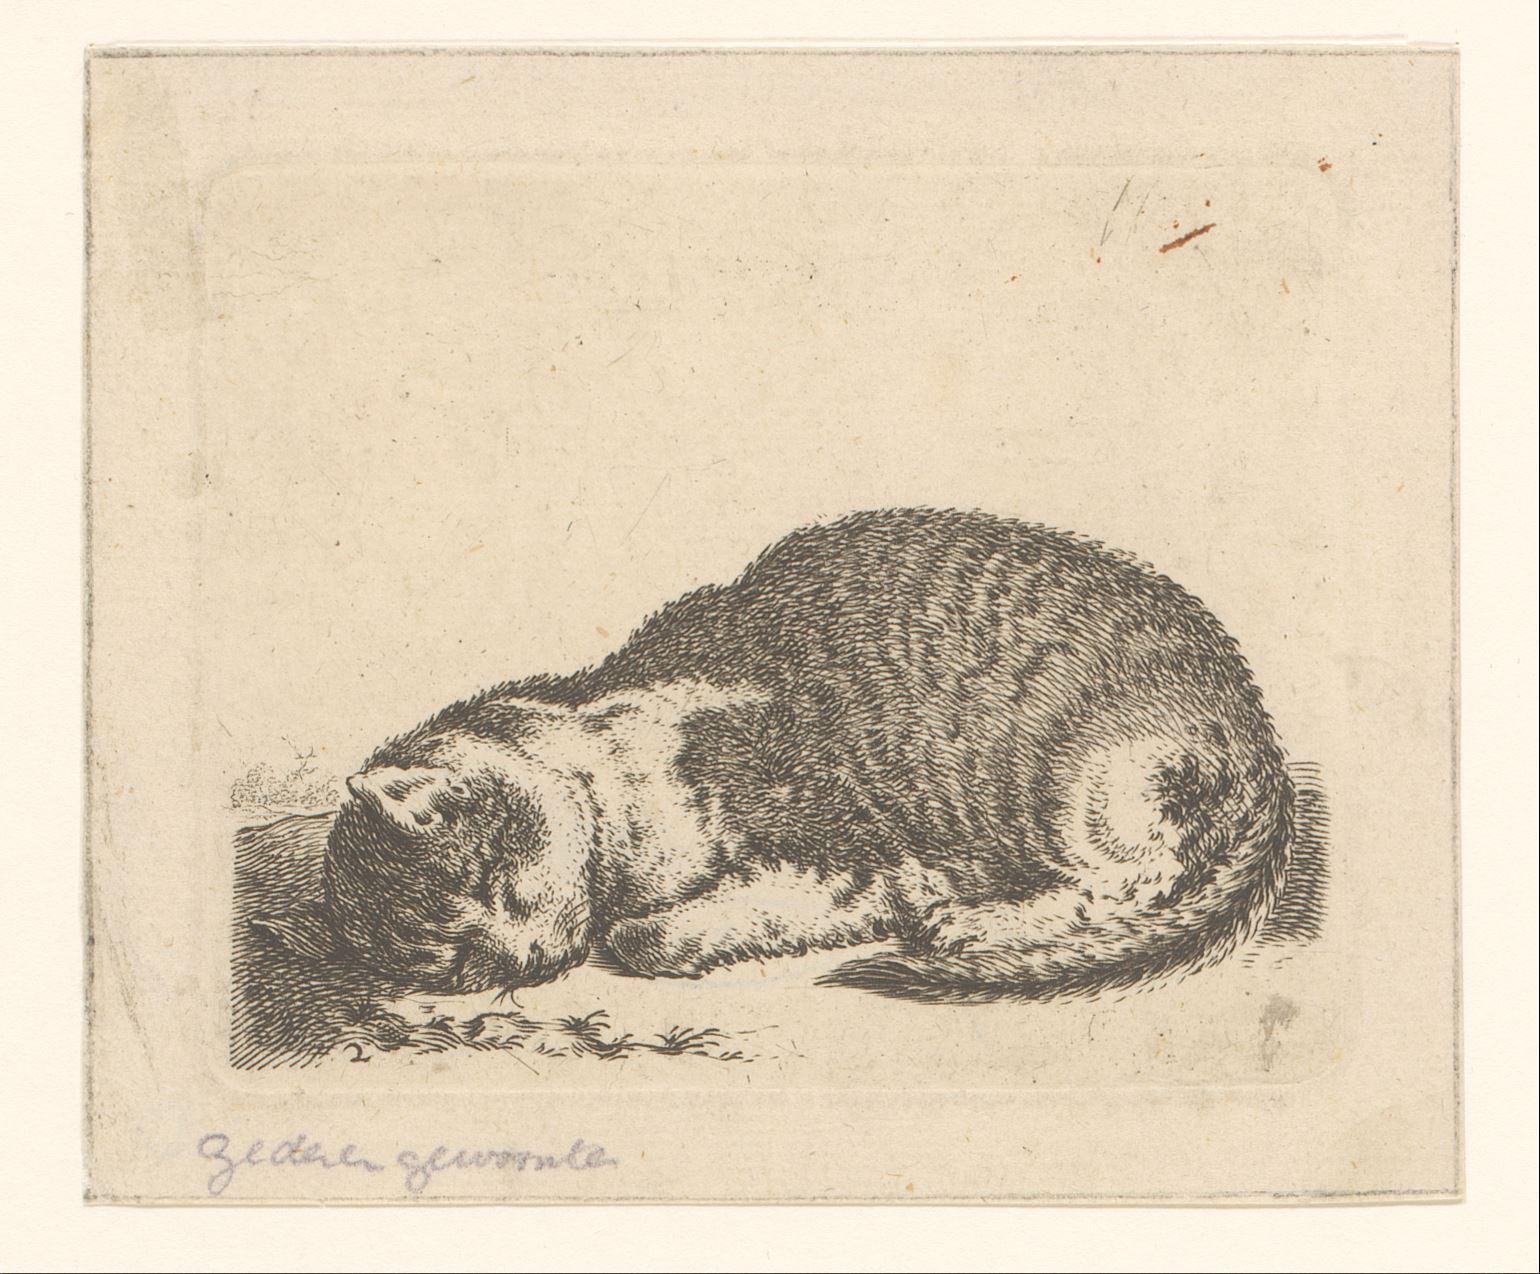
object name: print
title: Slapende poes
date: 1617-1681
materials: paper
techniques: etching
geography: amsterdam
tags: animals, cat, sleeping; unconsciousness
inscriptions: collector's mark: Lugt 2228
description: Maakt deel uit van een twaalfdelige serie met boerderijbeesten.